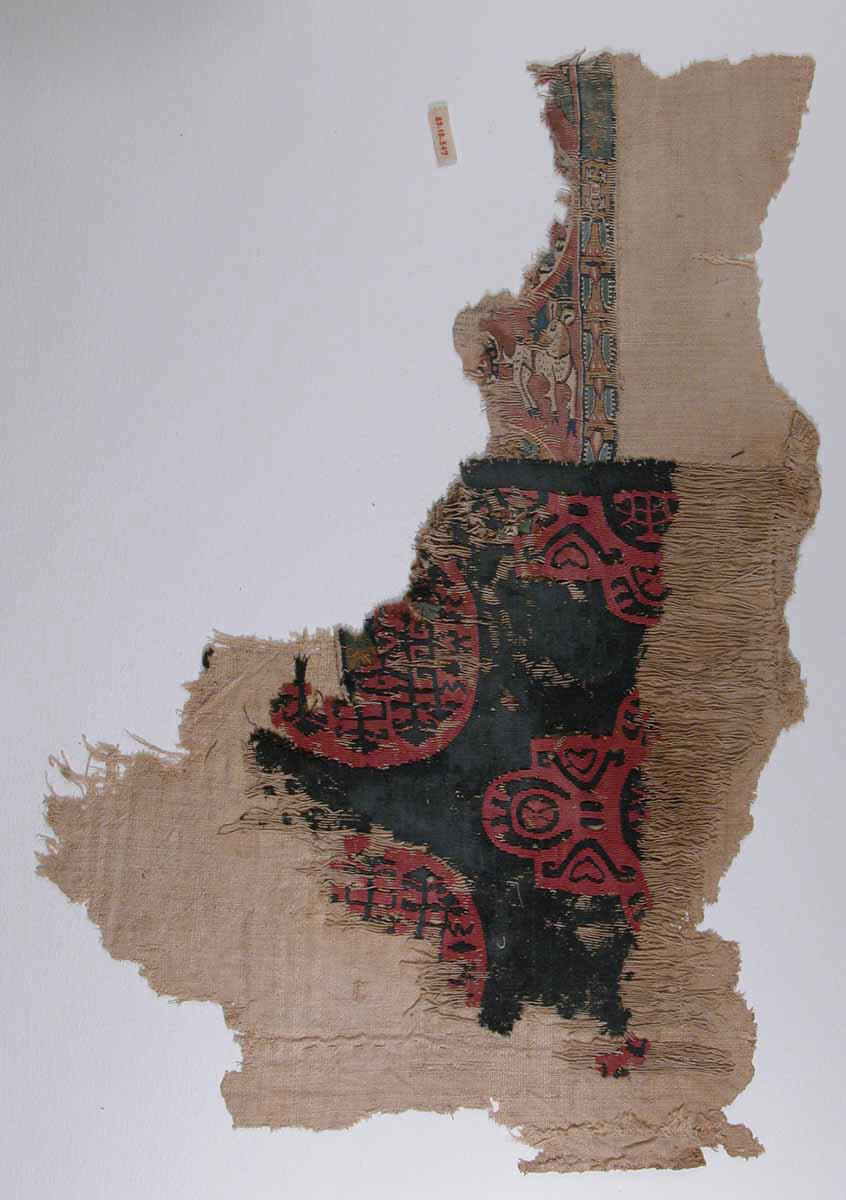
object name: textile fragment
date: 501-700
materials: linen, wool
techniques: weave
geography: egypt